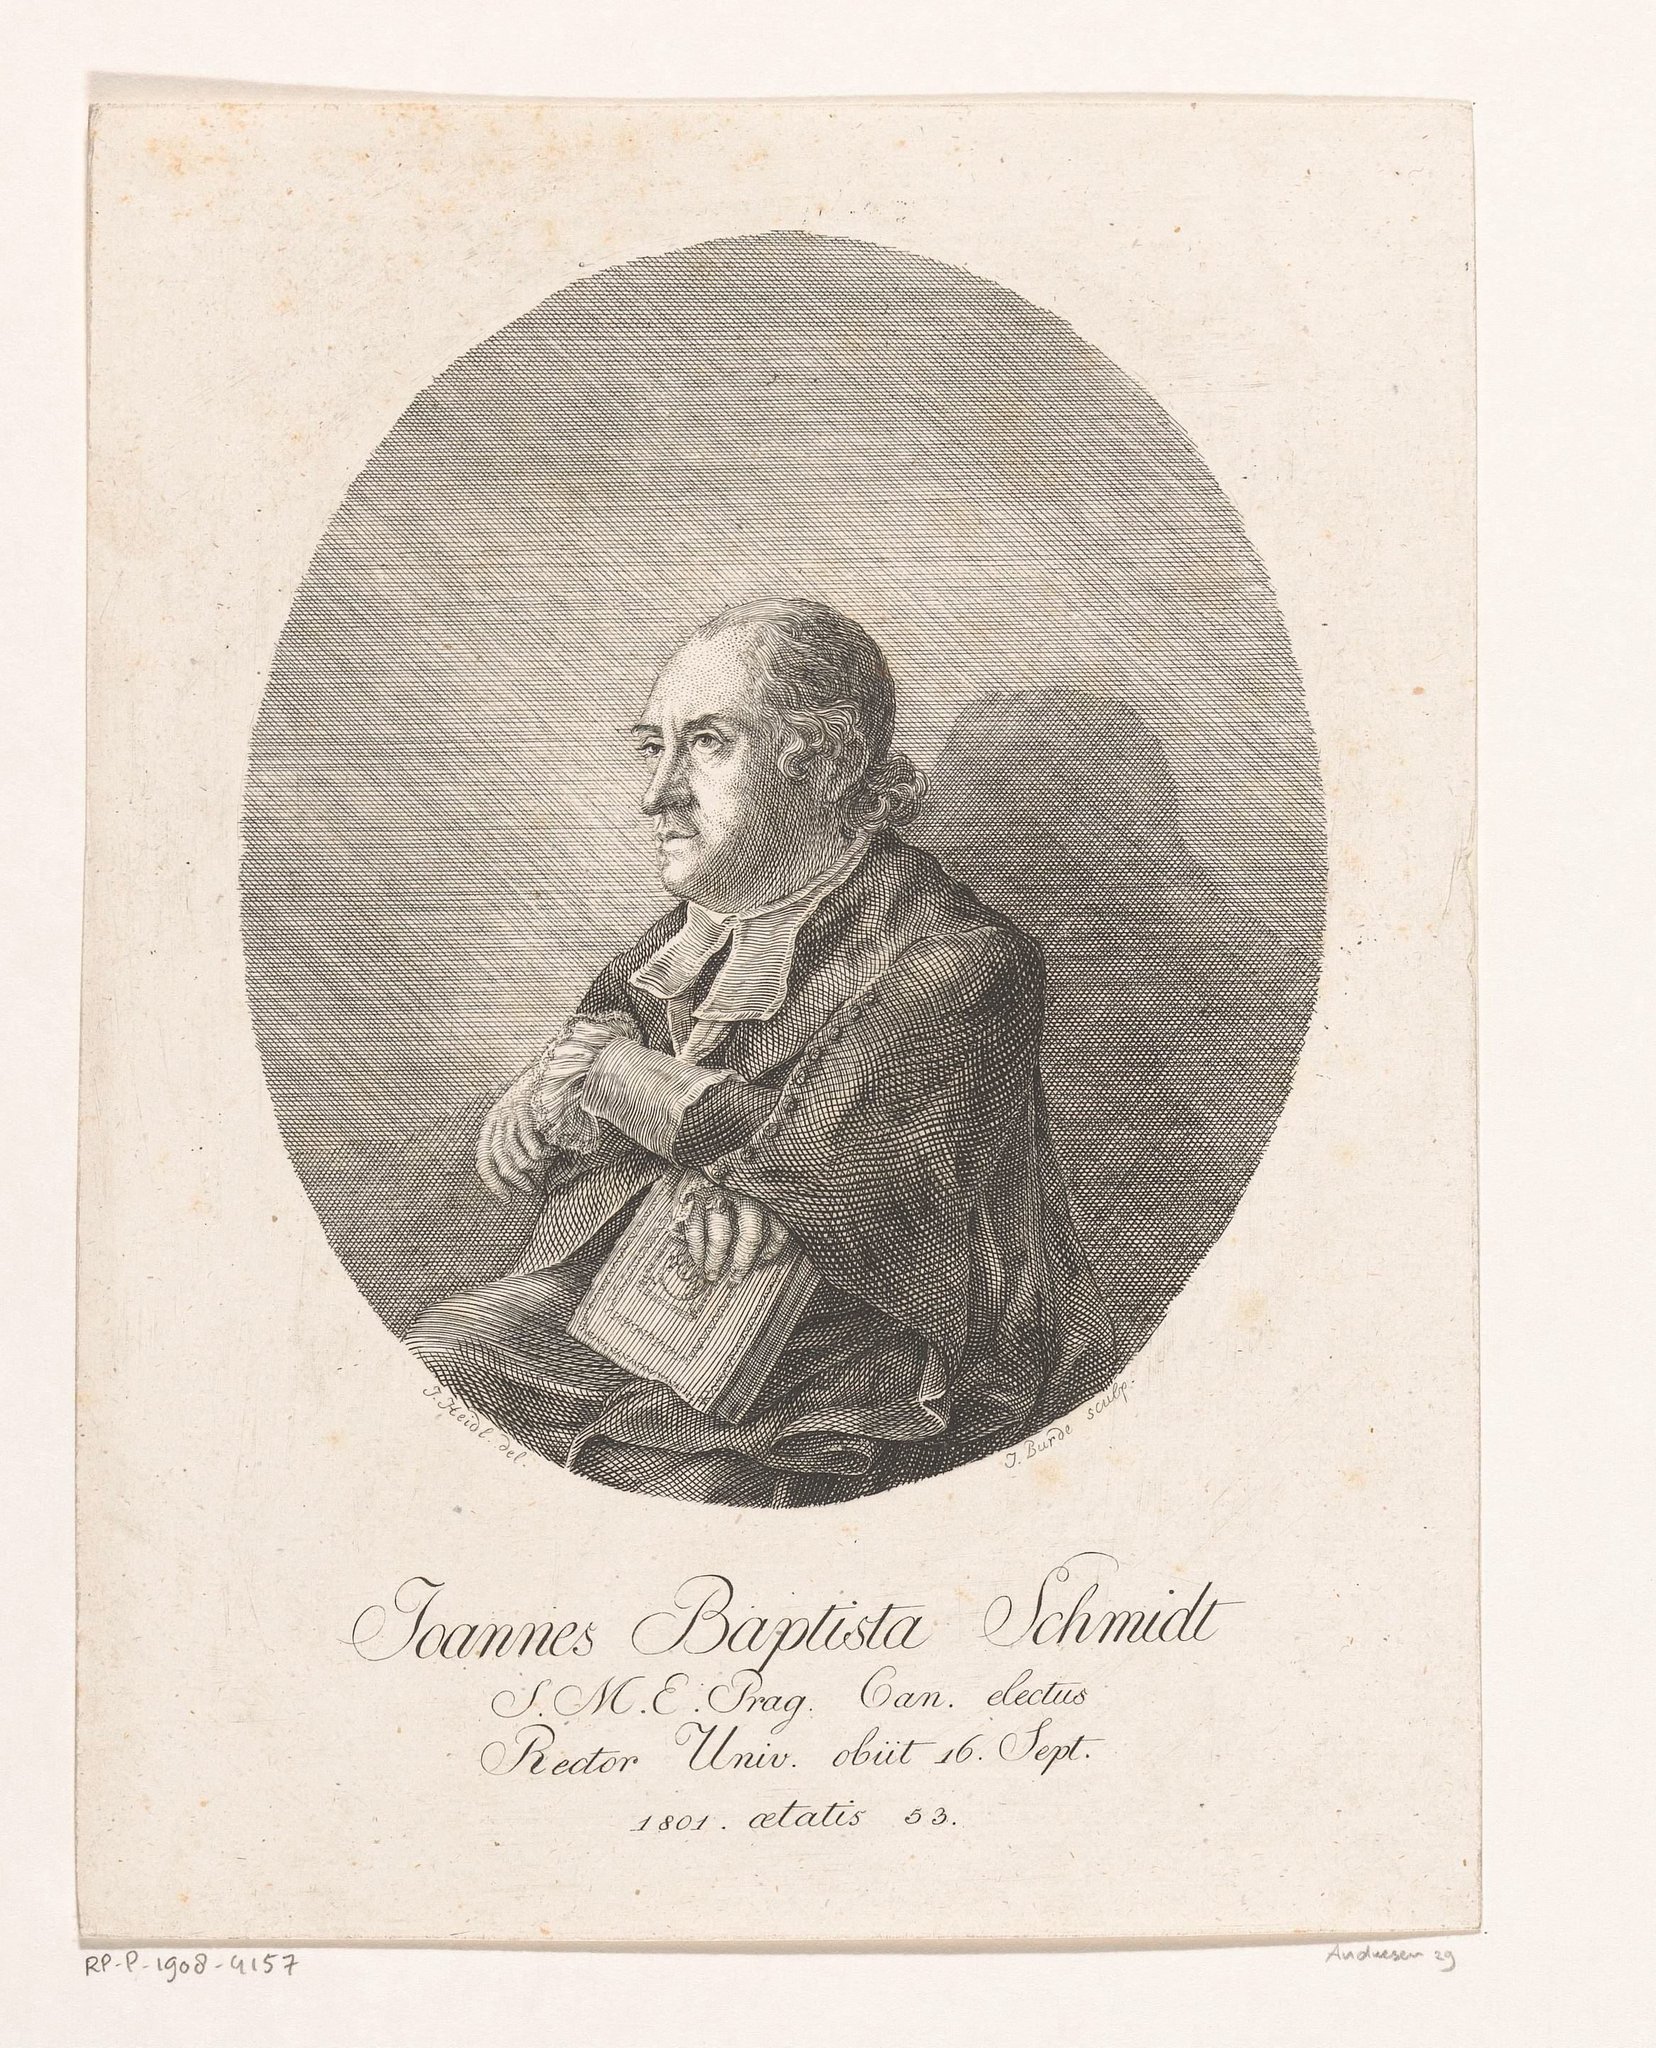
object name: print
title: Portret van Joannes Baptista Schmidt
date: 1802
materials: paper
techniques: engraving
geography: prague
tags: board, dignitaries of a university, historical persons, book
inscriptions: collector's mark: Lugt 2228